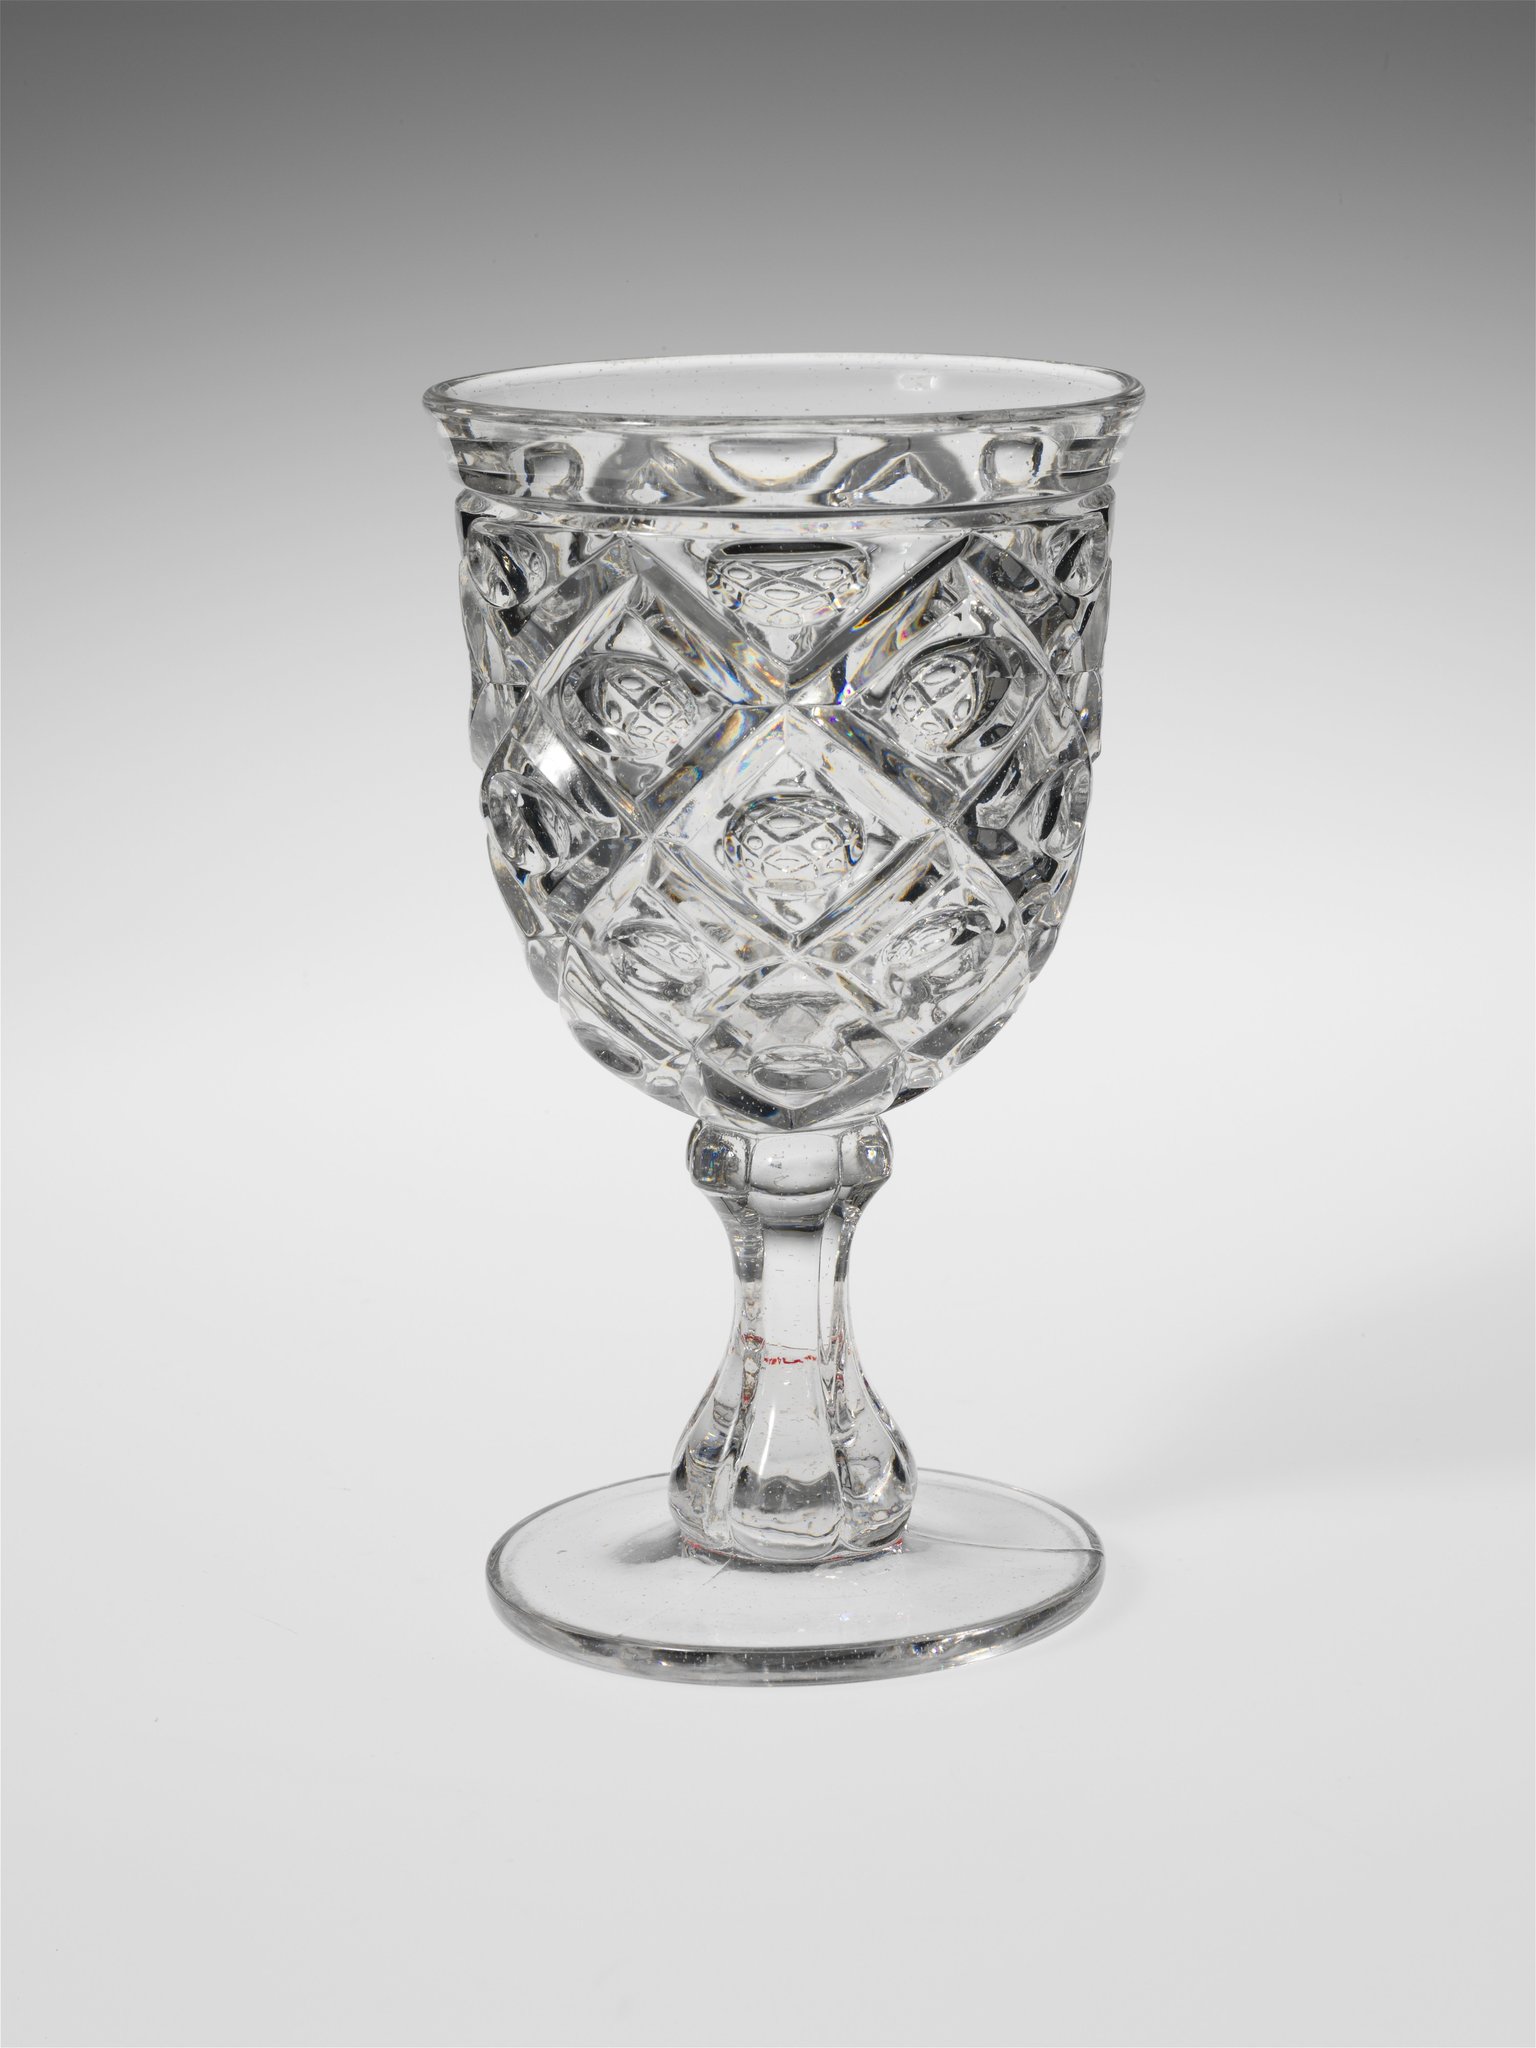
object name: goblet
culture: american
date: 1850-1860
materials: diamond, glass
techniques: pressed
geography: united states